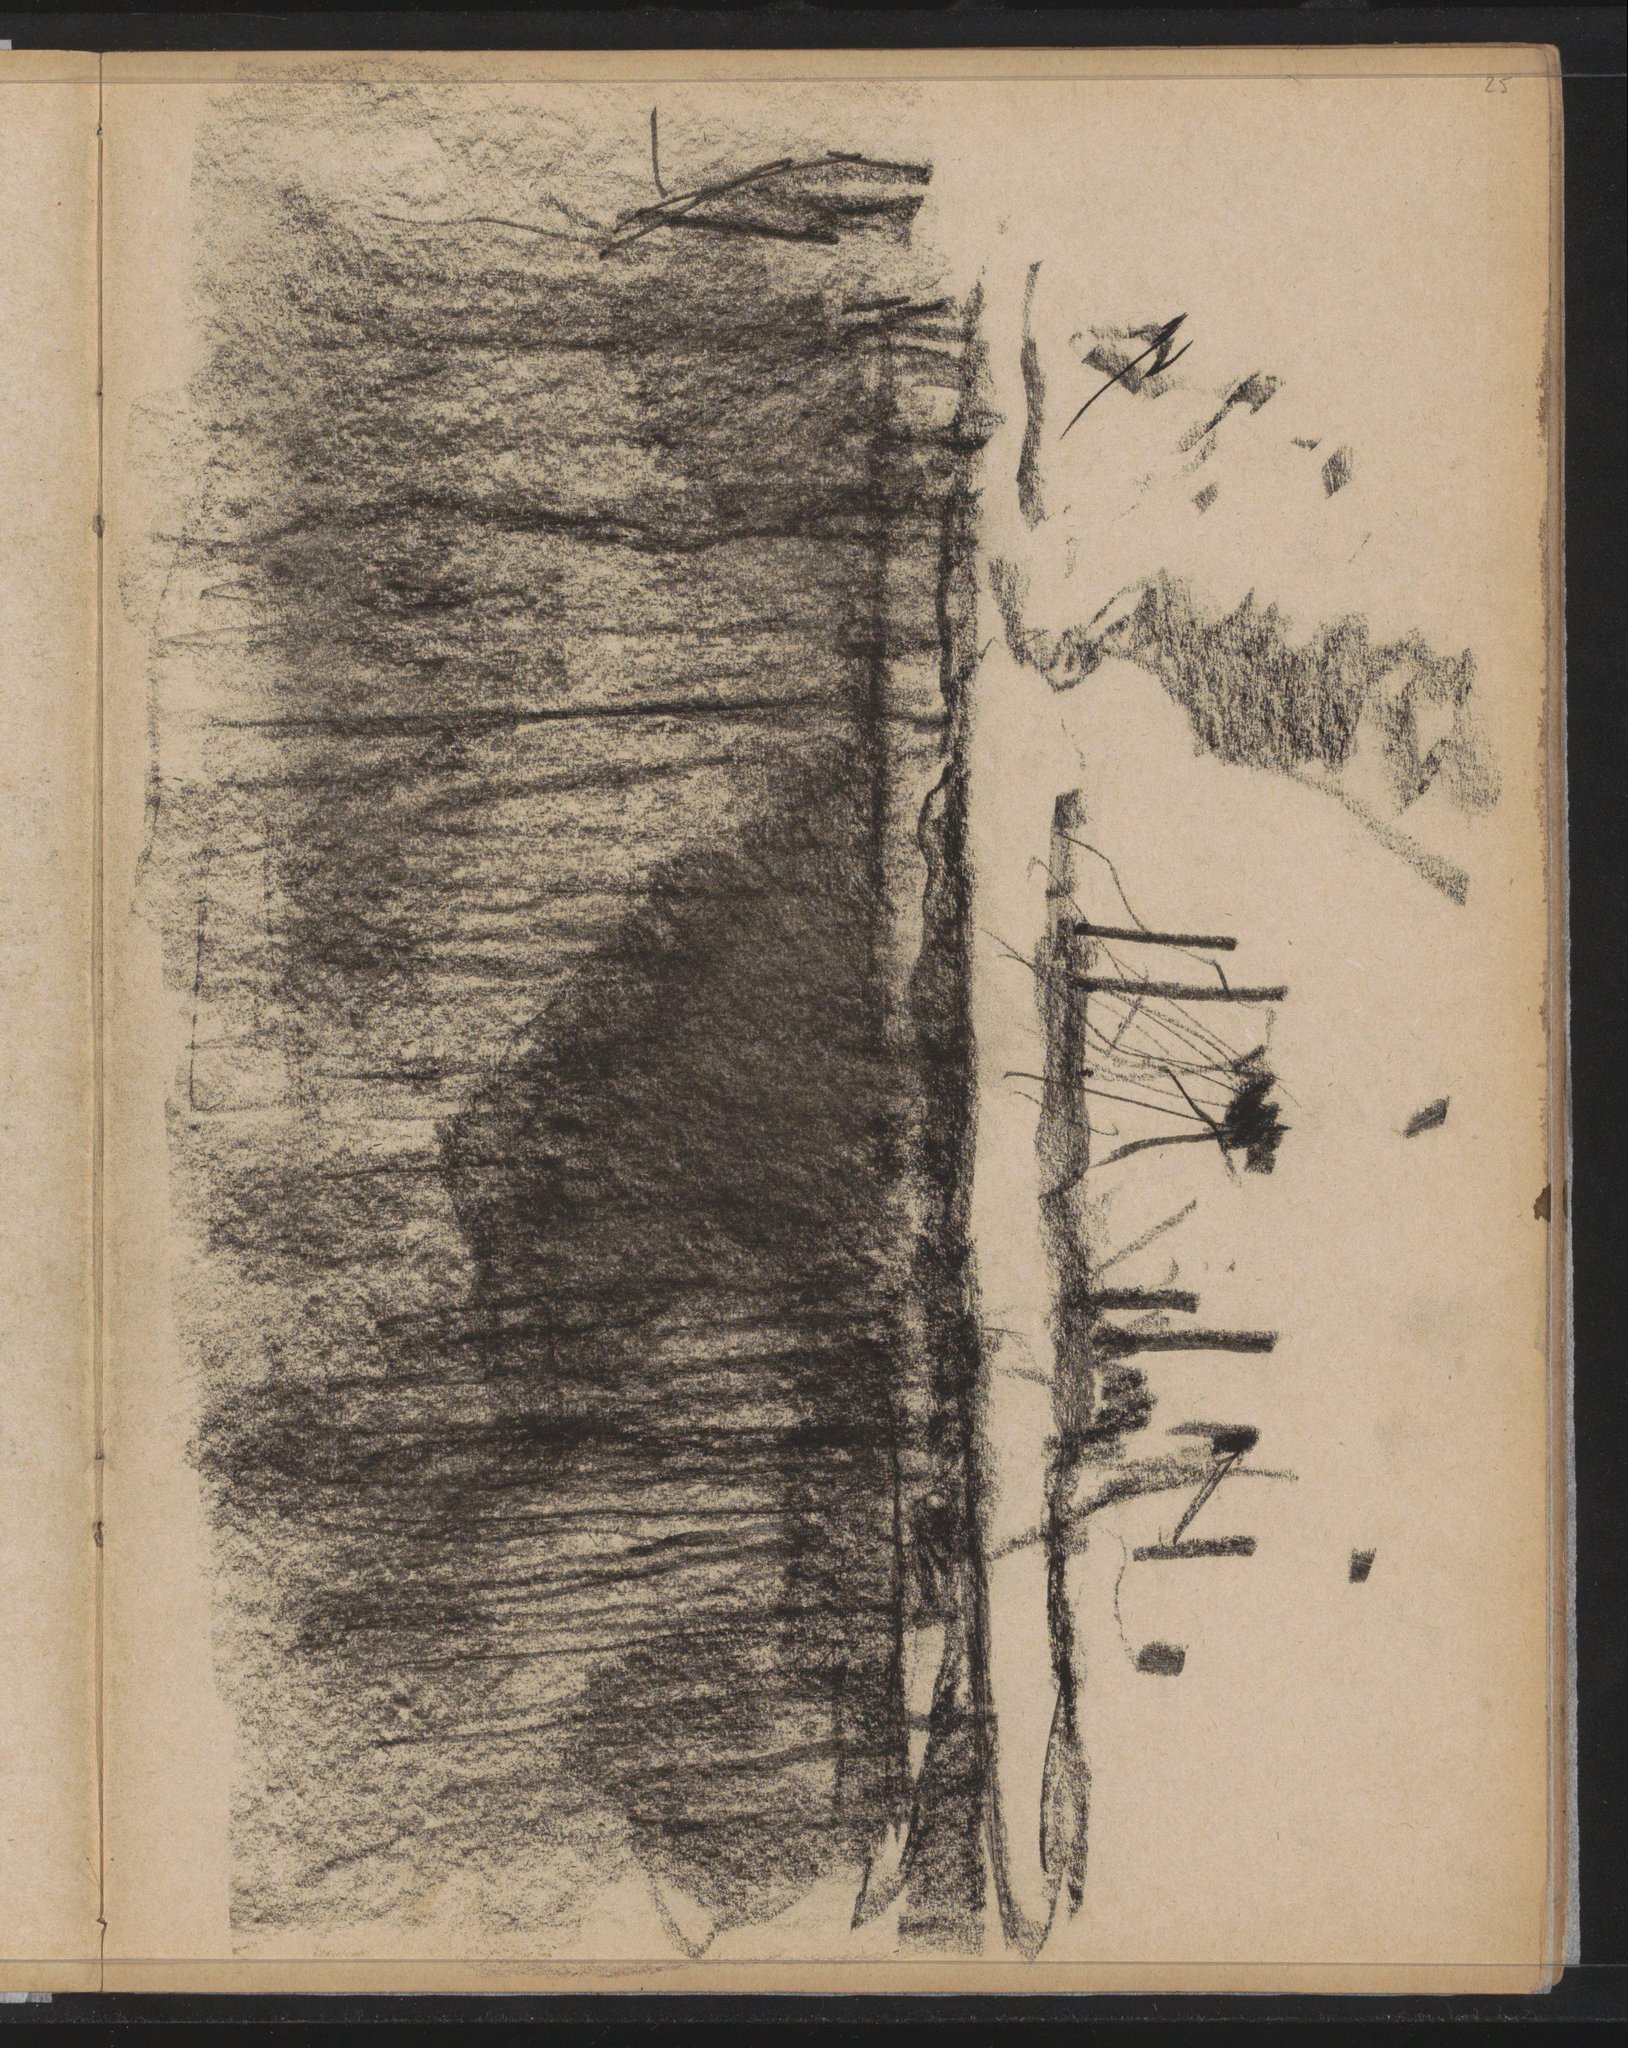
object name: sketchbook leaf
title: Landschap met bebouwing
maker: willem witsen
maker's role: draughtsman, painter, print maker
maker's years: 1860-1923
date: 1887-1888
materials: chalk, paper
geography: ewijkshoeve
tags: landscapes, snow, civic architecture; edifices; dwellings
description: Mogelijk besneeuwd. Pagina 25 uit een schetsboek met 43 bladen.